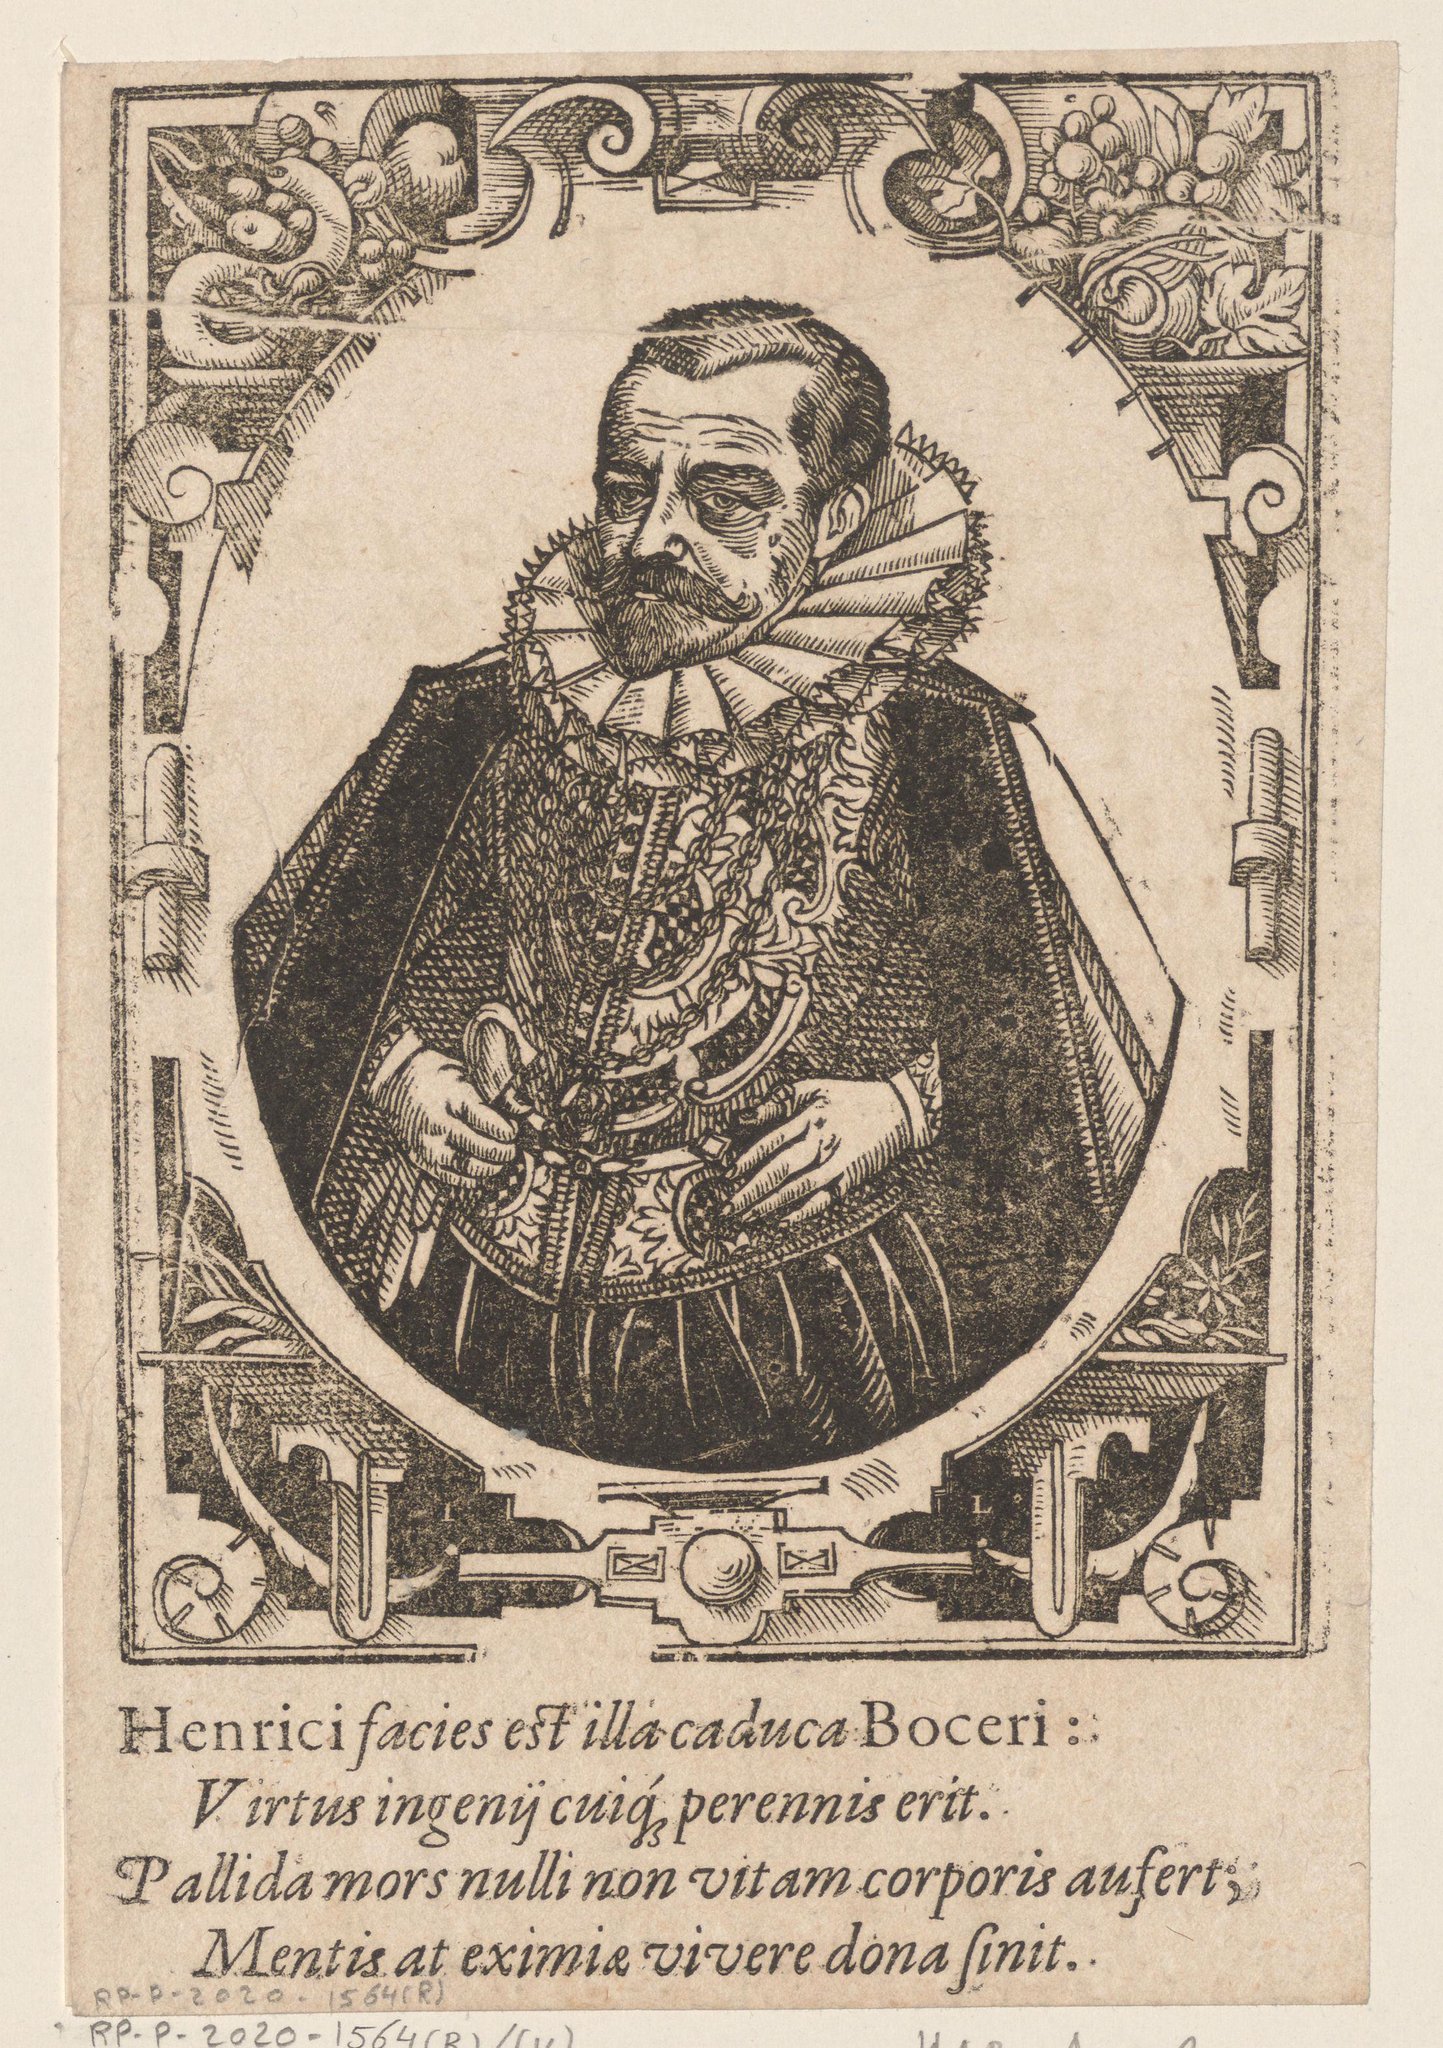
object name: print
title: Portret van Heinrich Bocer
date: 1612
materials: paper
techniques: letterpress printing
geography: tübingen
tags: historical persons, portrait of a writer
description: Prent uit: Bocer, Heinrich. Disputationum de universo, quo utimur, (...). Tübingen: Dietrich Werlin, 1612, dl. 1.